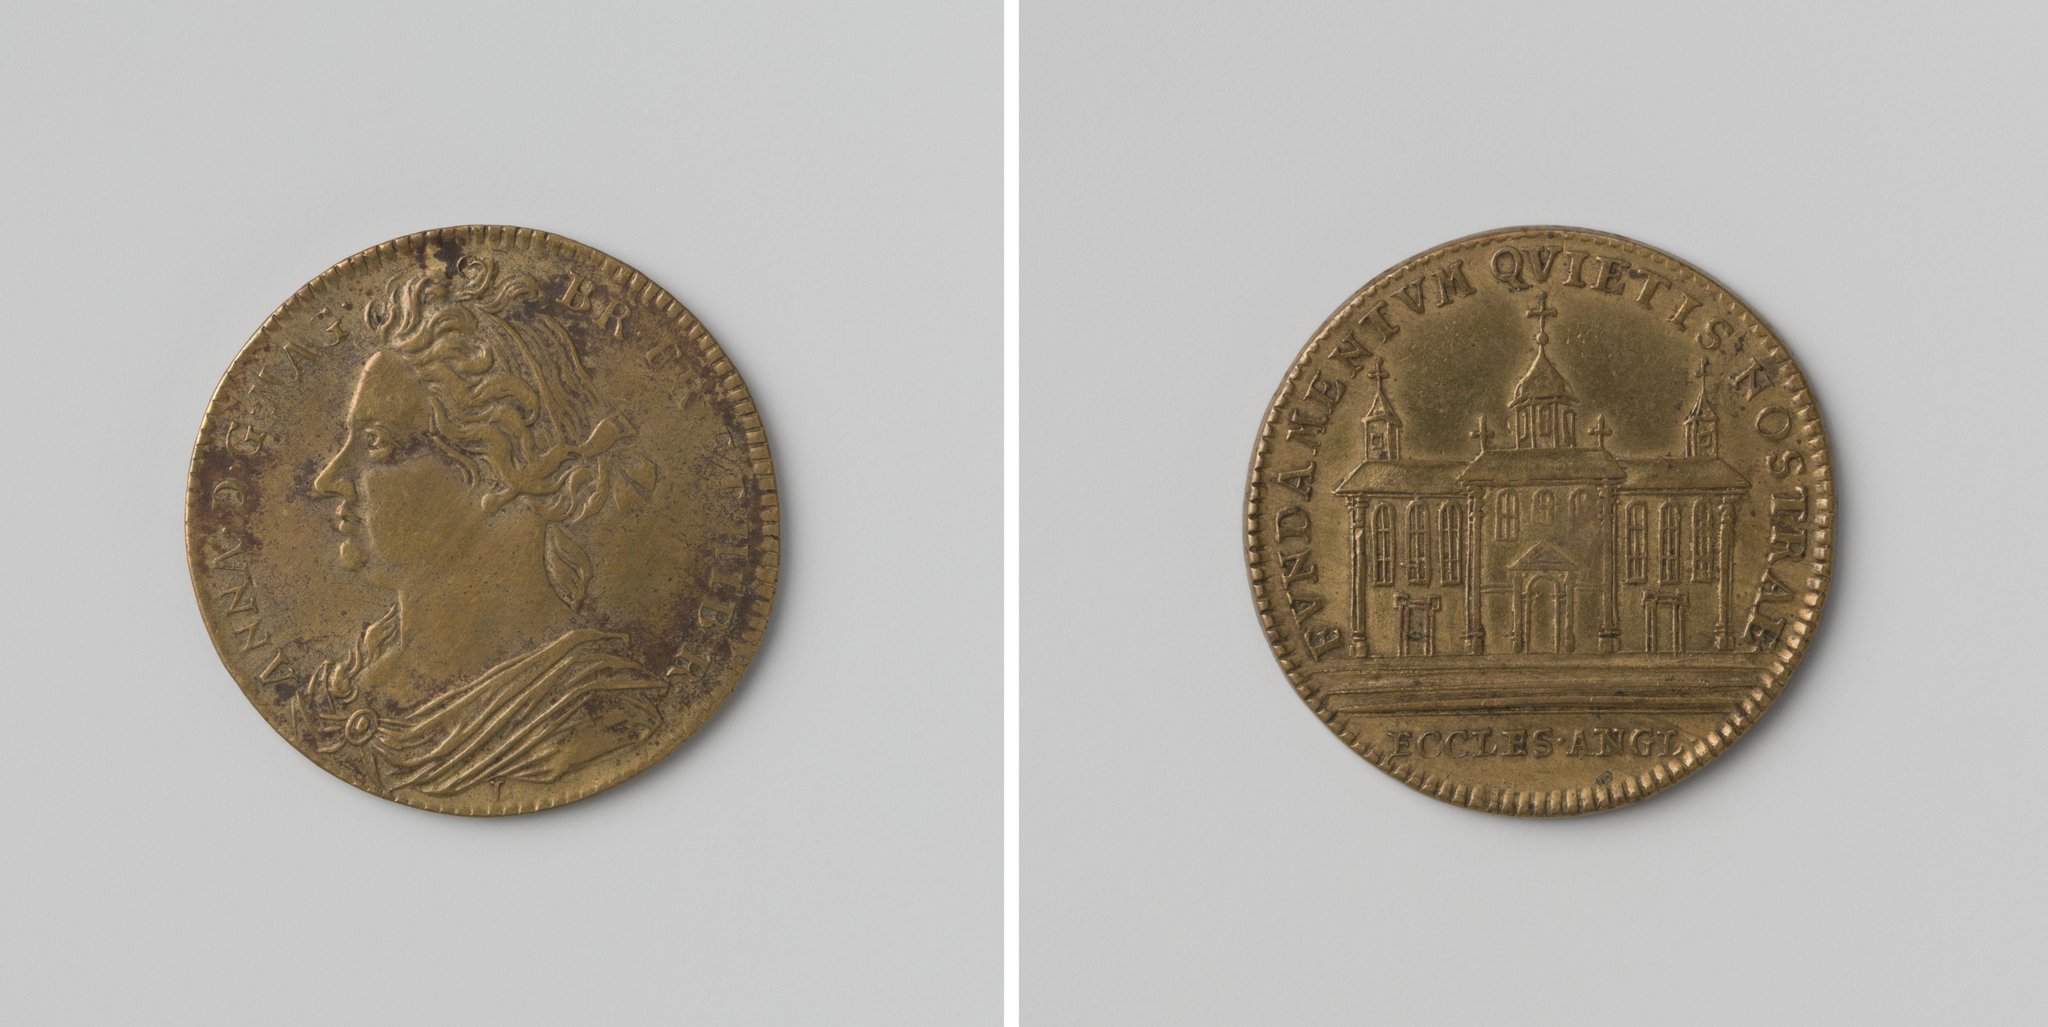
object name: jeton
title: Anglicaanse kerk als fundament van de Engelse samenleving, rekenpenning geslagen ter ere van Anna Stuart, koningin van Engeland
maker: lauffer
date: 1702-1714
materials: brass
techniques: striking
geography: nuremberg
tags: london, anna stuart (koningin van engeland en schotland)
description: Messing penning. Voorzijde: borststuk vrouw binnen omschrift. Keerzijde: kerkgebouw binnen omschrift; afsnede: opschrift